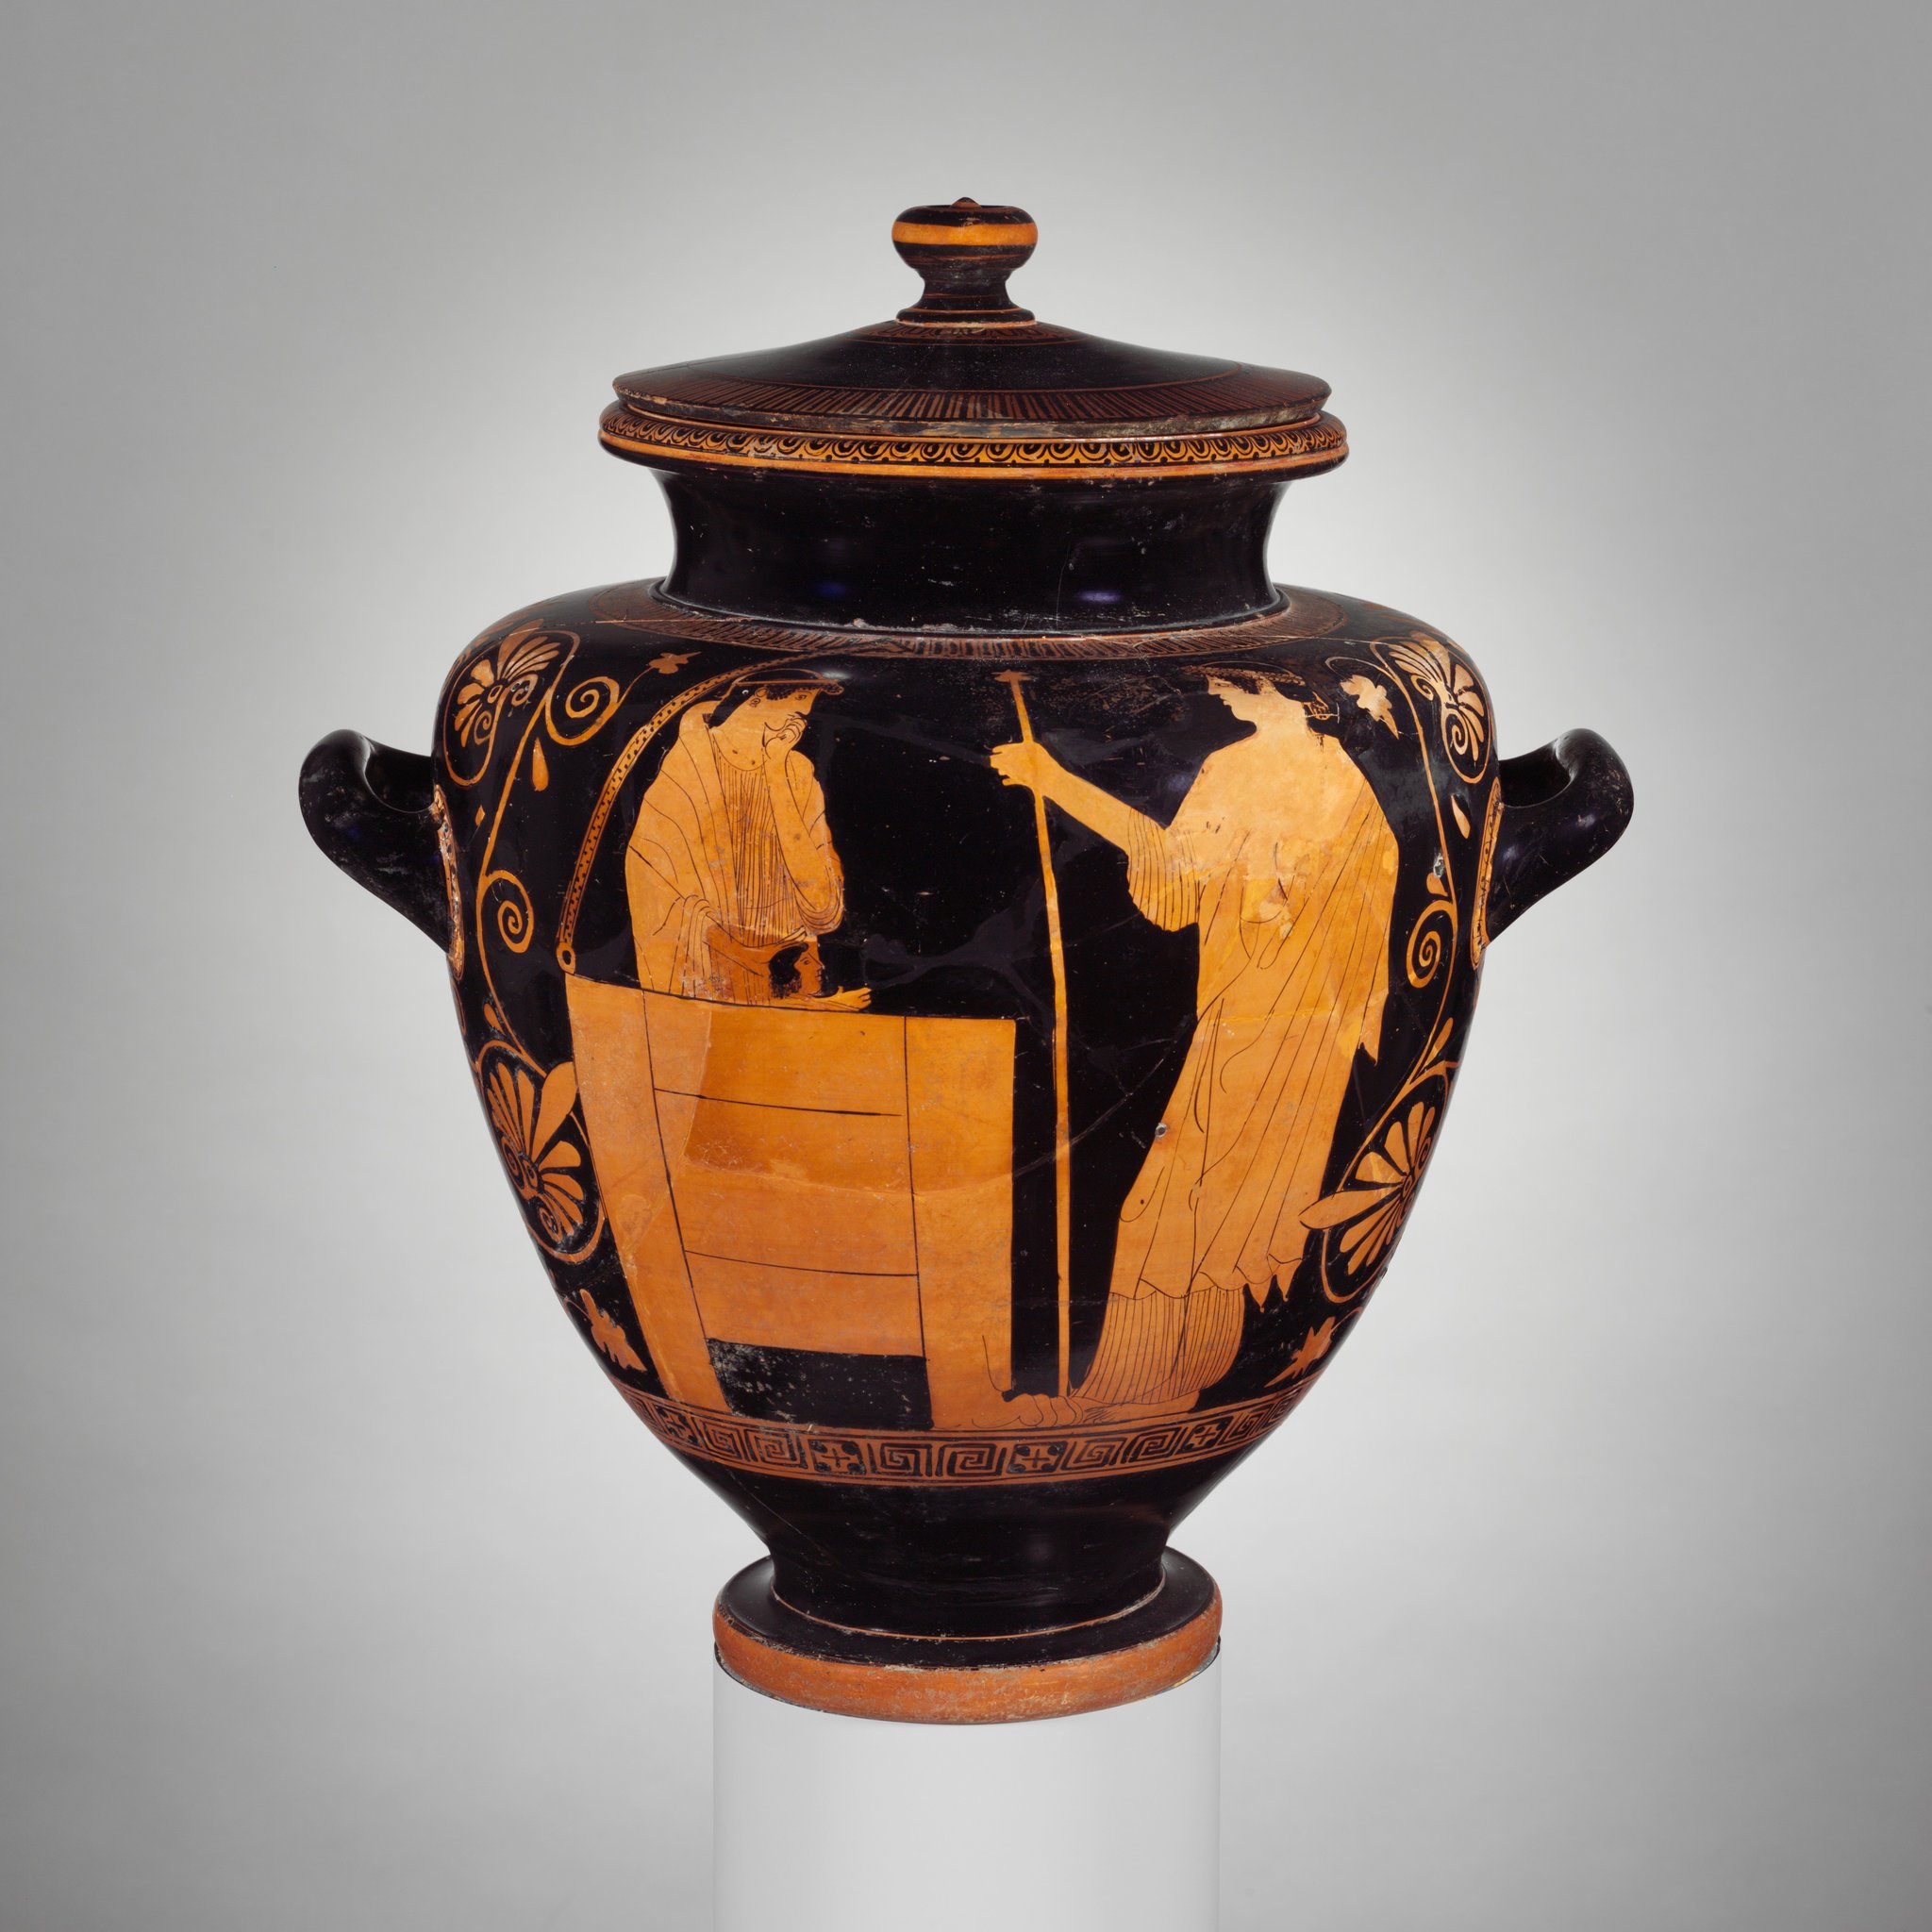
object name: stamnos with lid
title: Terracotta stamnos with cover (jar)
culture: greek, attic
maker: deepdene painter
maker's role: artist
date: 470-460 BCE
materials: terracotta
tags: men,women,perseus,chests